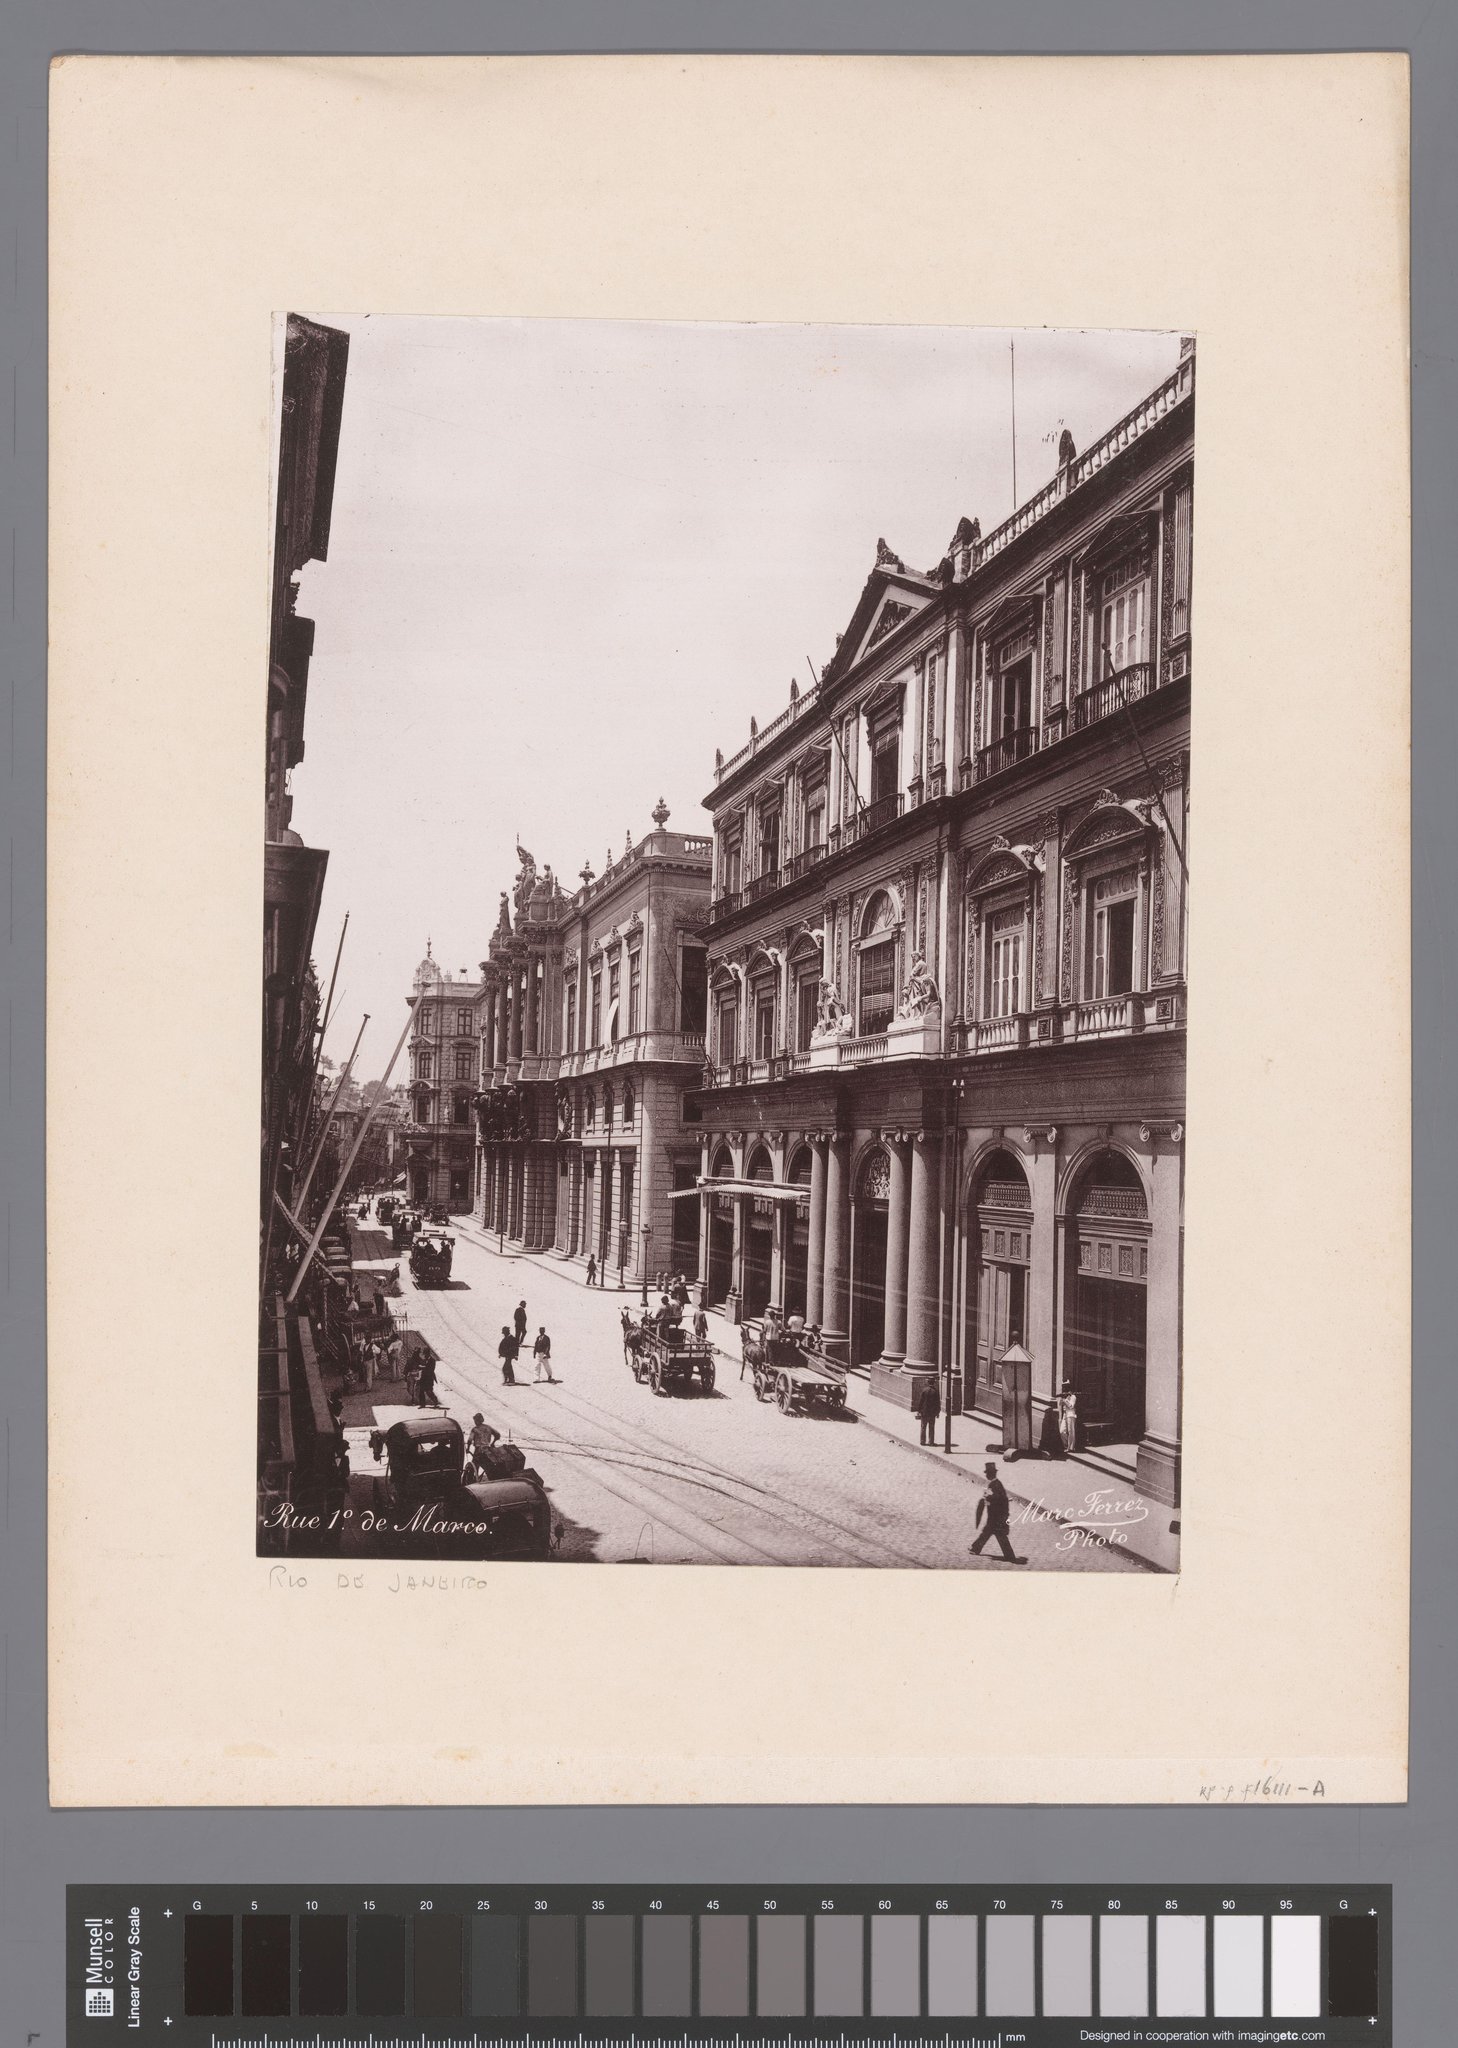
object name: photomechanical print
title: Rue 1e de Marco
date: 1890-1910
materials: cardboard, paper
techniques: photograph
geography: rio de janeiro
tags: city-view, and landscape with man-made constructions